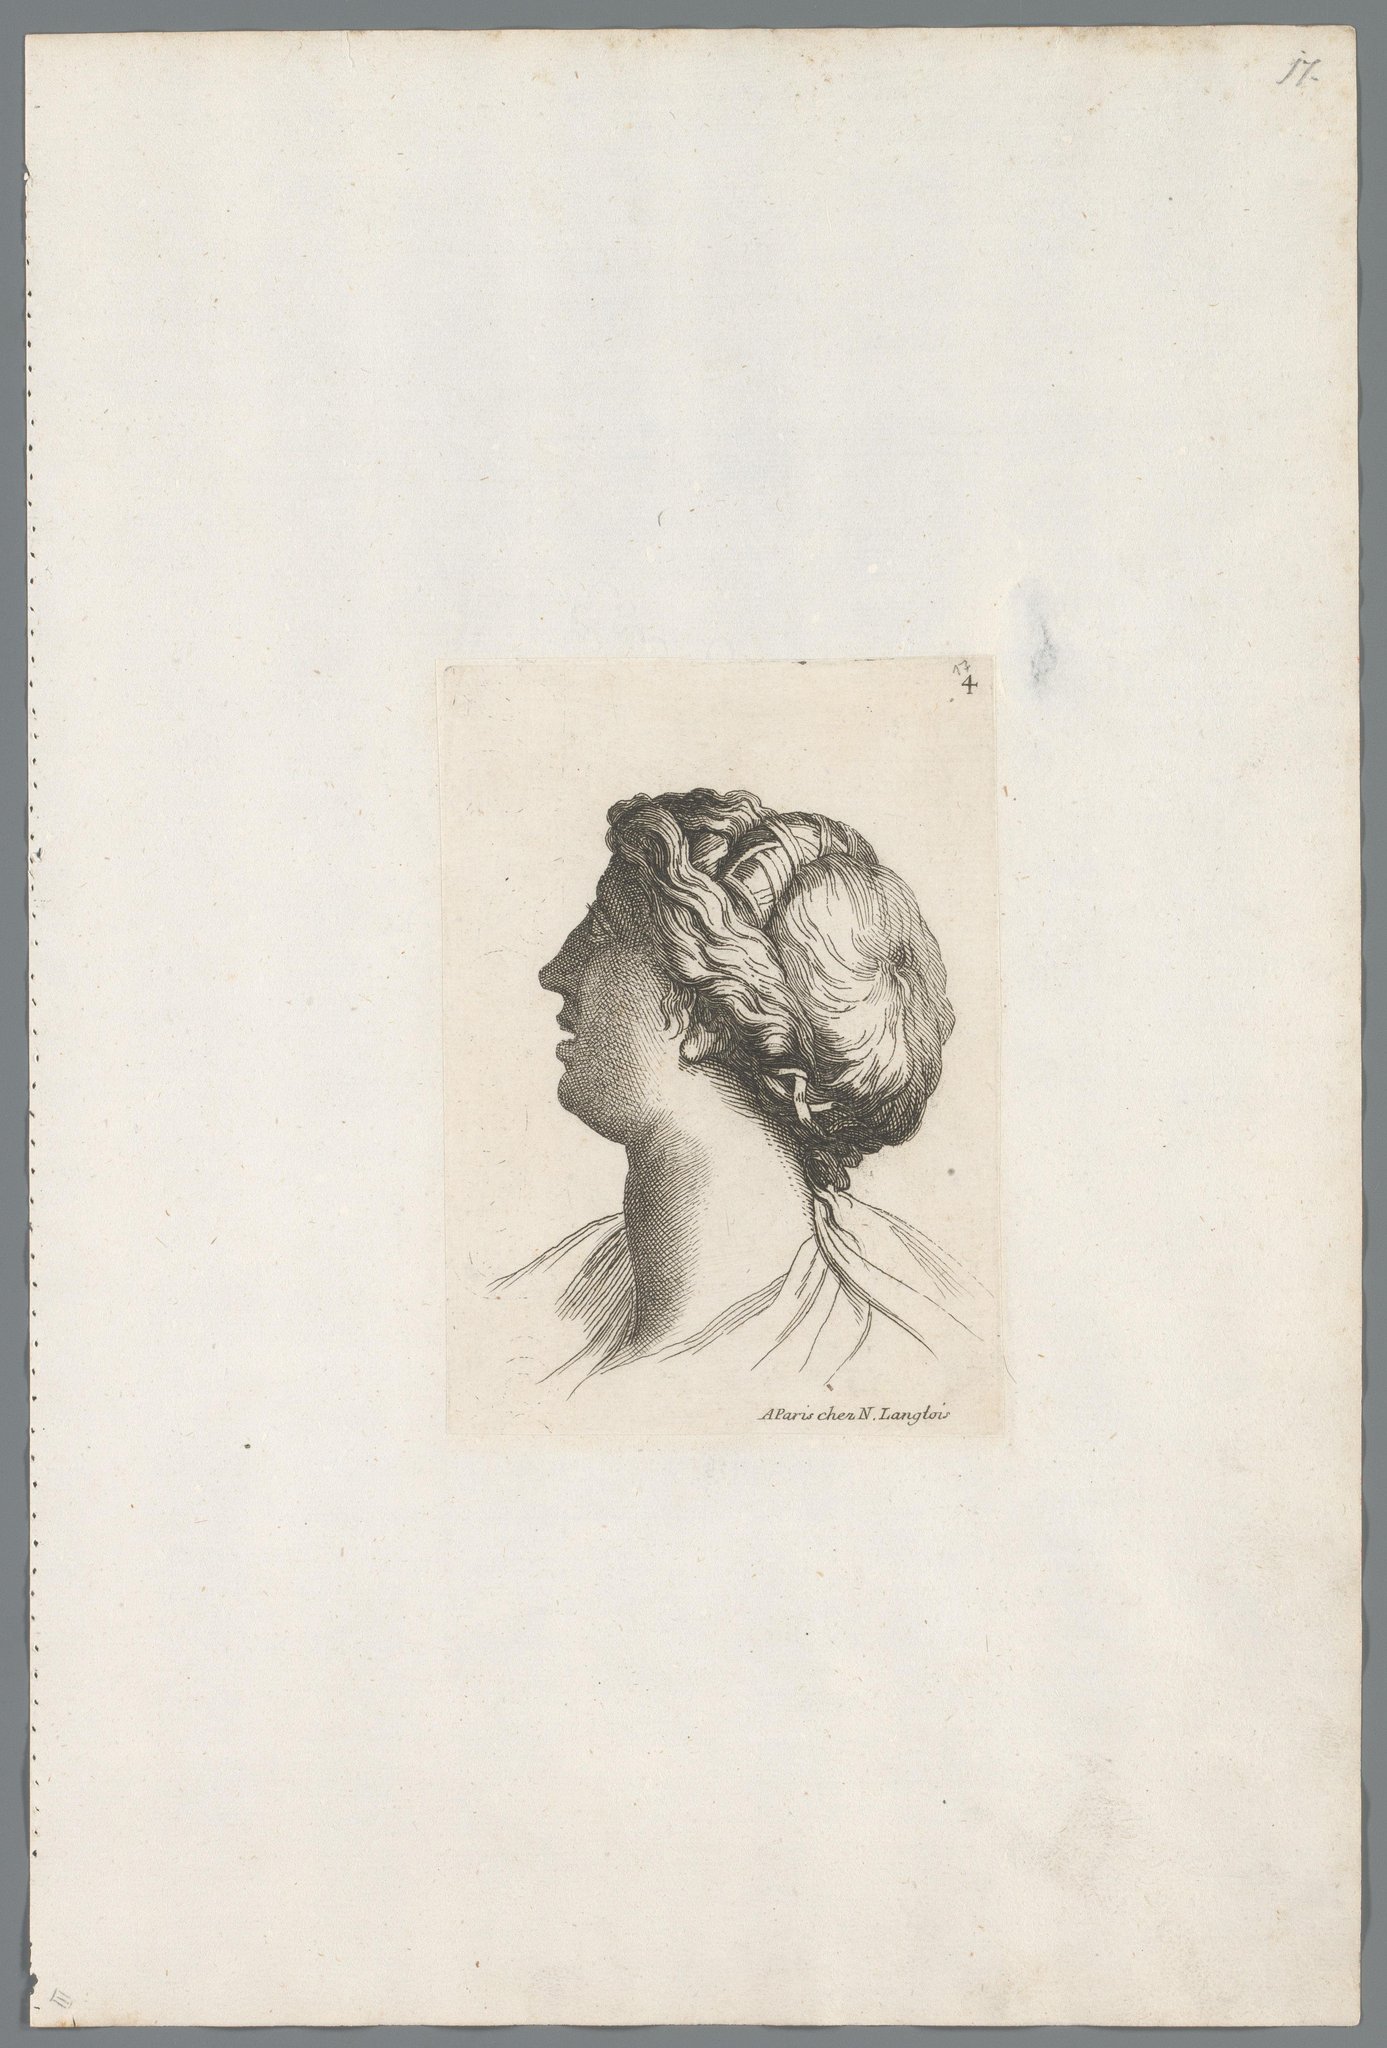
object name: print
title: Hoofd van een weg kijkende vrouw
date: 1650-1703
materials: paper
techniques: engraving, etching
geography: paris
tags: anonymous historical person portrayed - bb - woman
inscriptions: collector's mark: Lugt 2228, collector's mark: Lugt 2760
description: Prent uit een serie met op elke prent een hoofd uit een schilderij van Poussin.